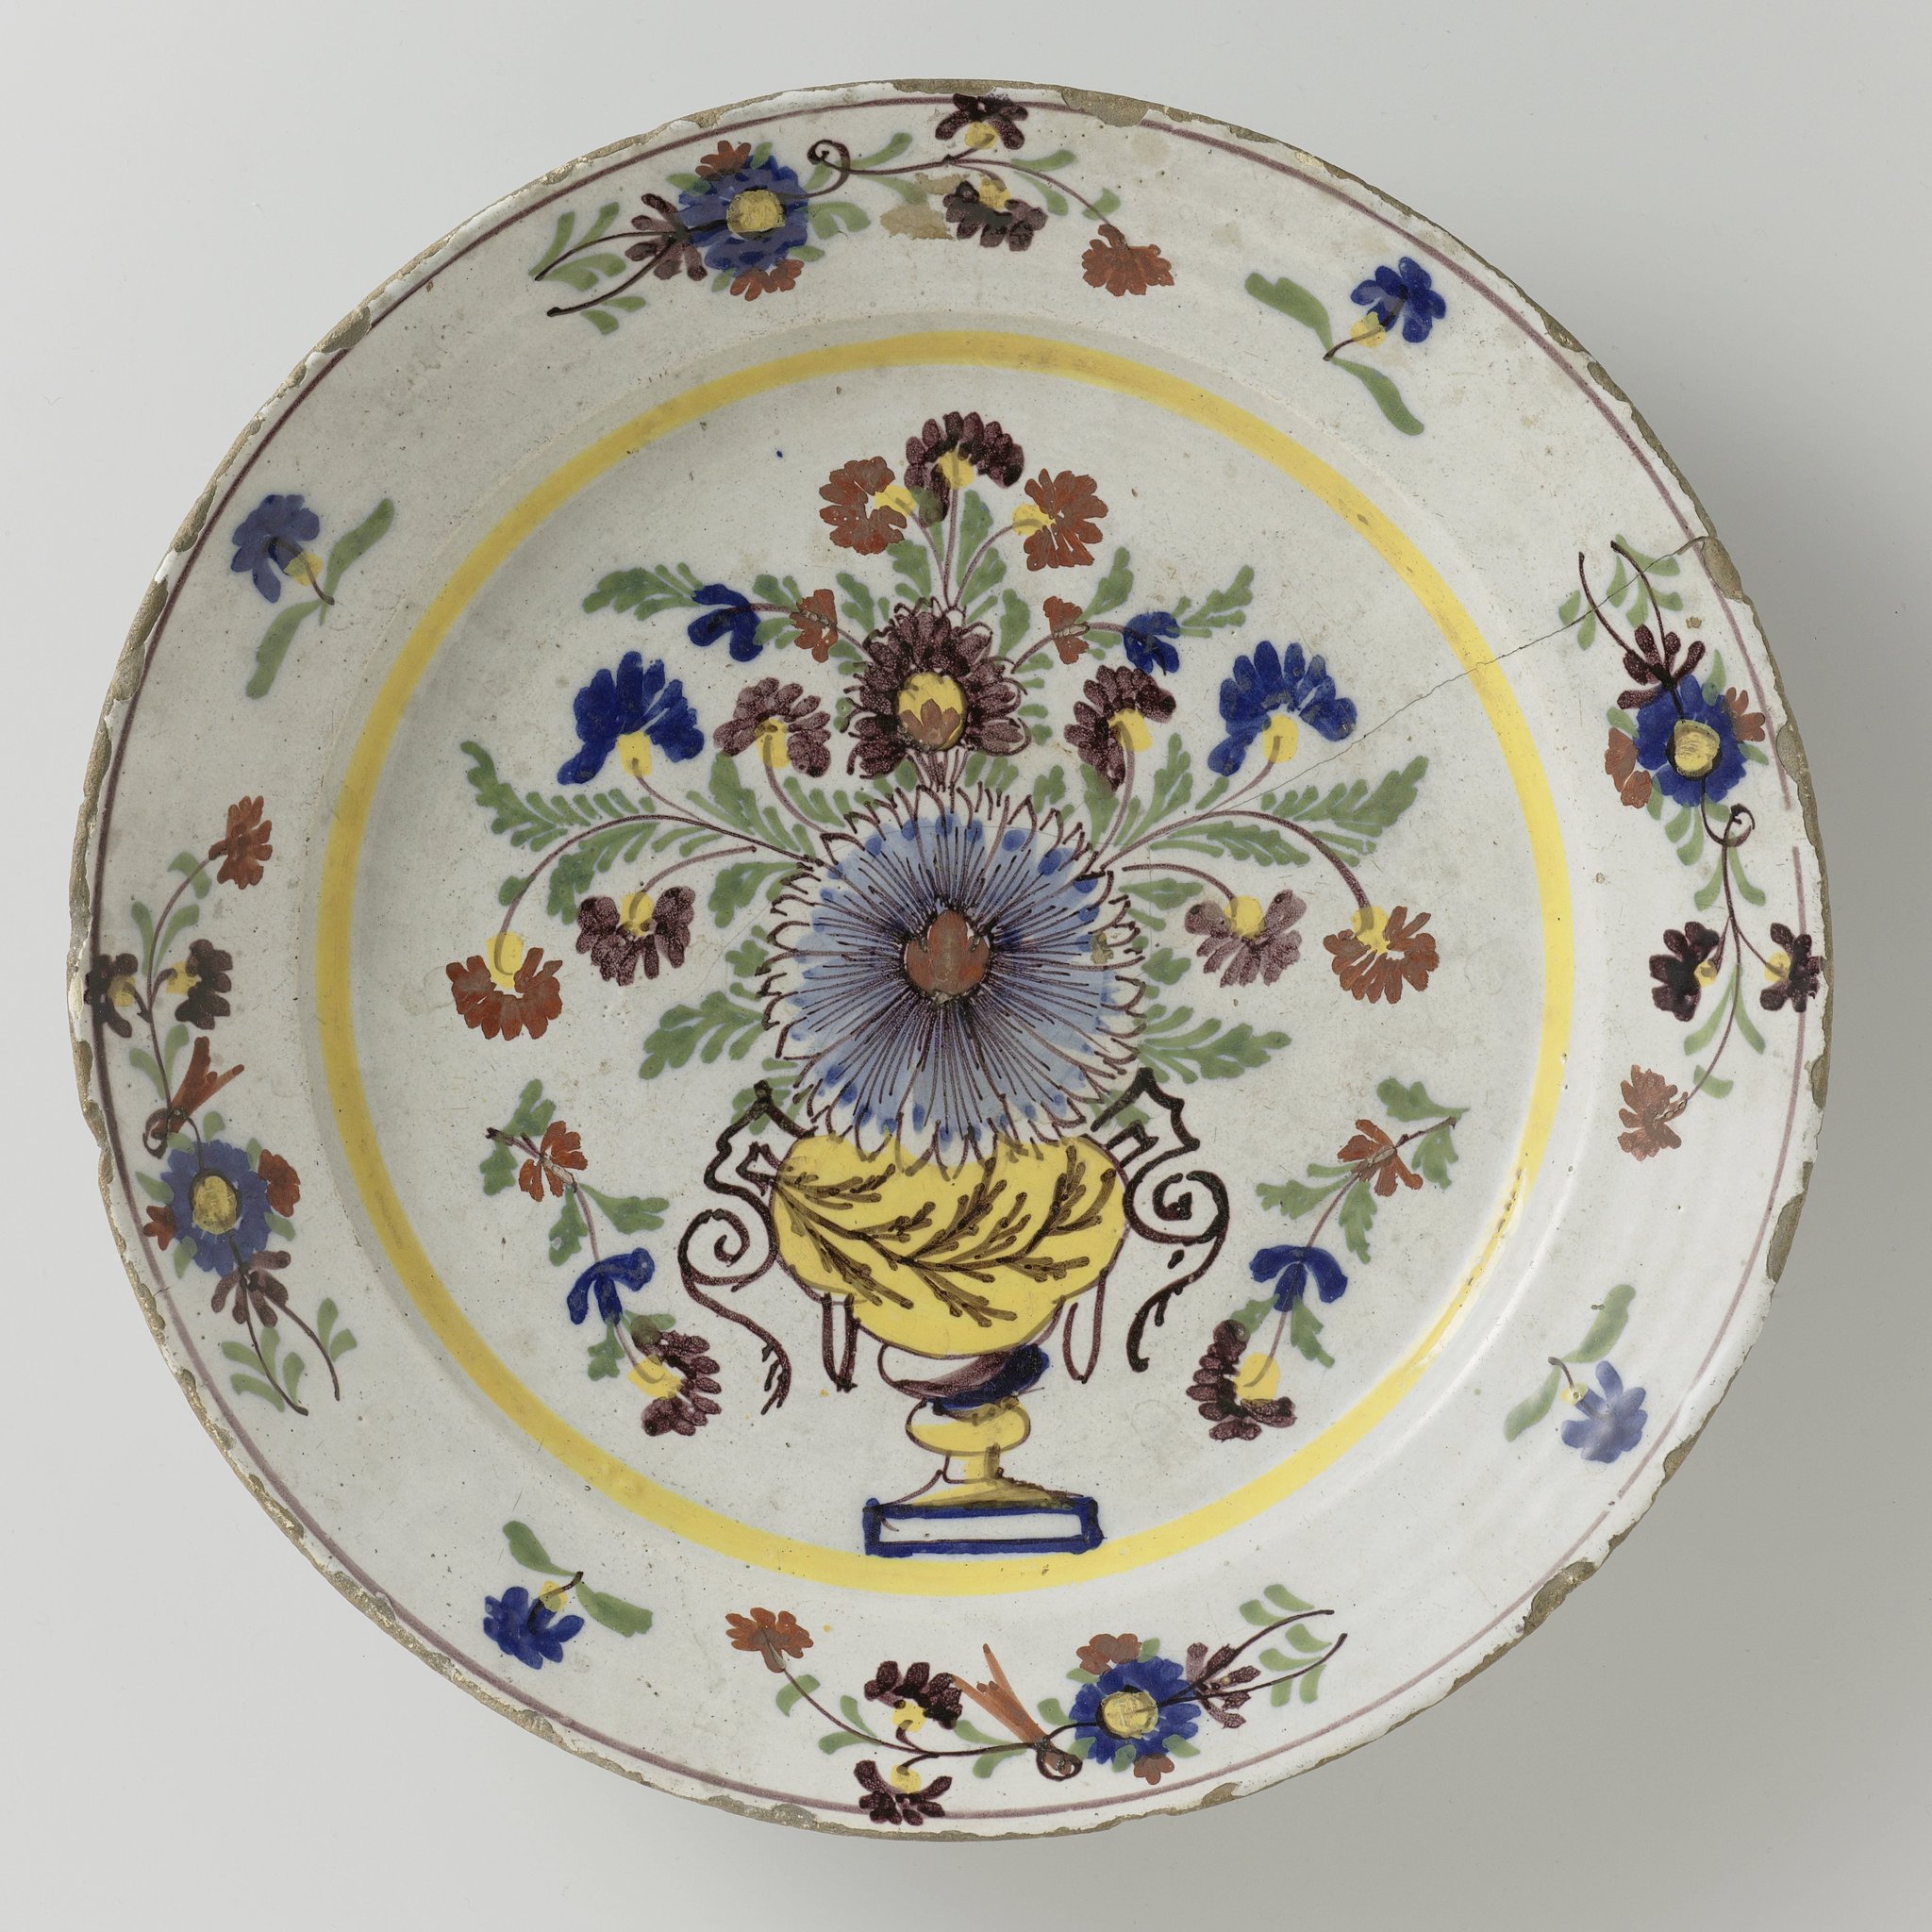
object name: platter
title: Schotel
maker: Anonymous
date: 1770-1820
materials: earthenware, glaze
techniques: painted, polychromy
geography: delft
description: Ronde schotel van veelkleurig beschilderde faience. Op het plat is een vaas met bloemen en op de rand zijn vier bloemenranken geschilderd. Bij de schotel hoort een identieke schotel met invnr. BK-NM-13354-a.